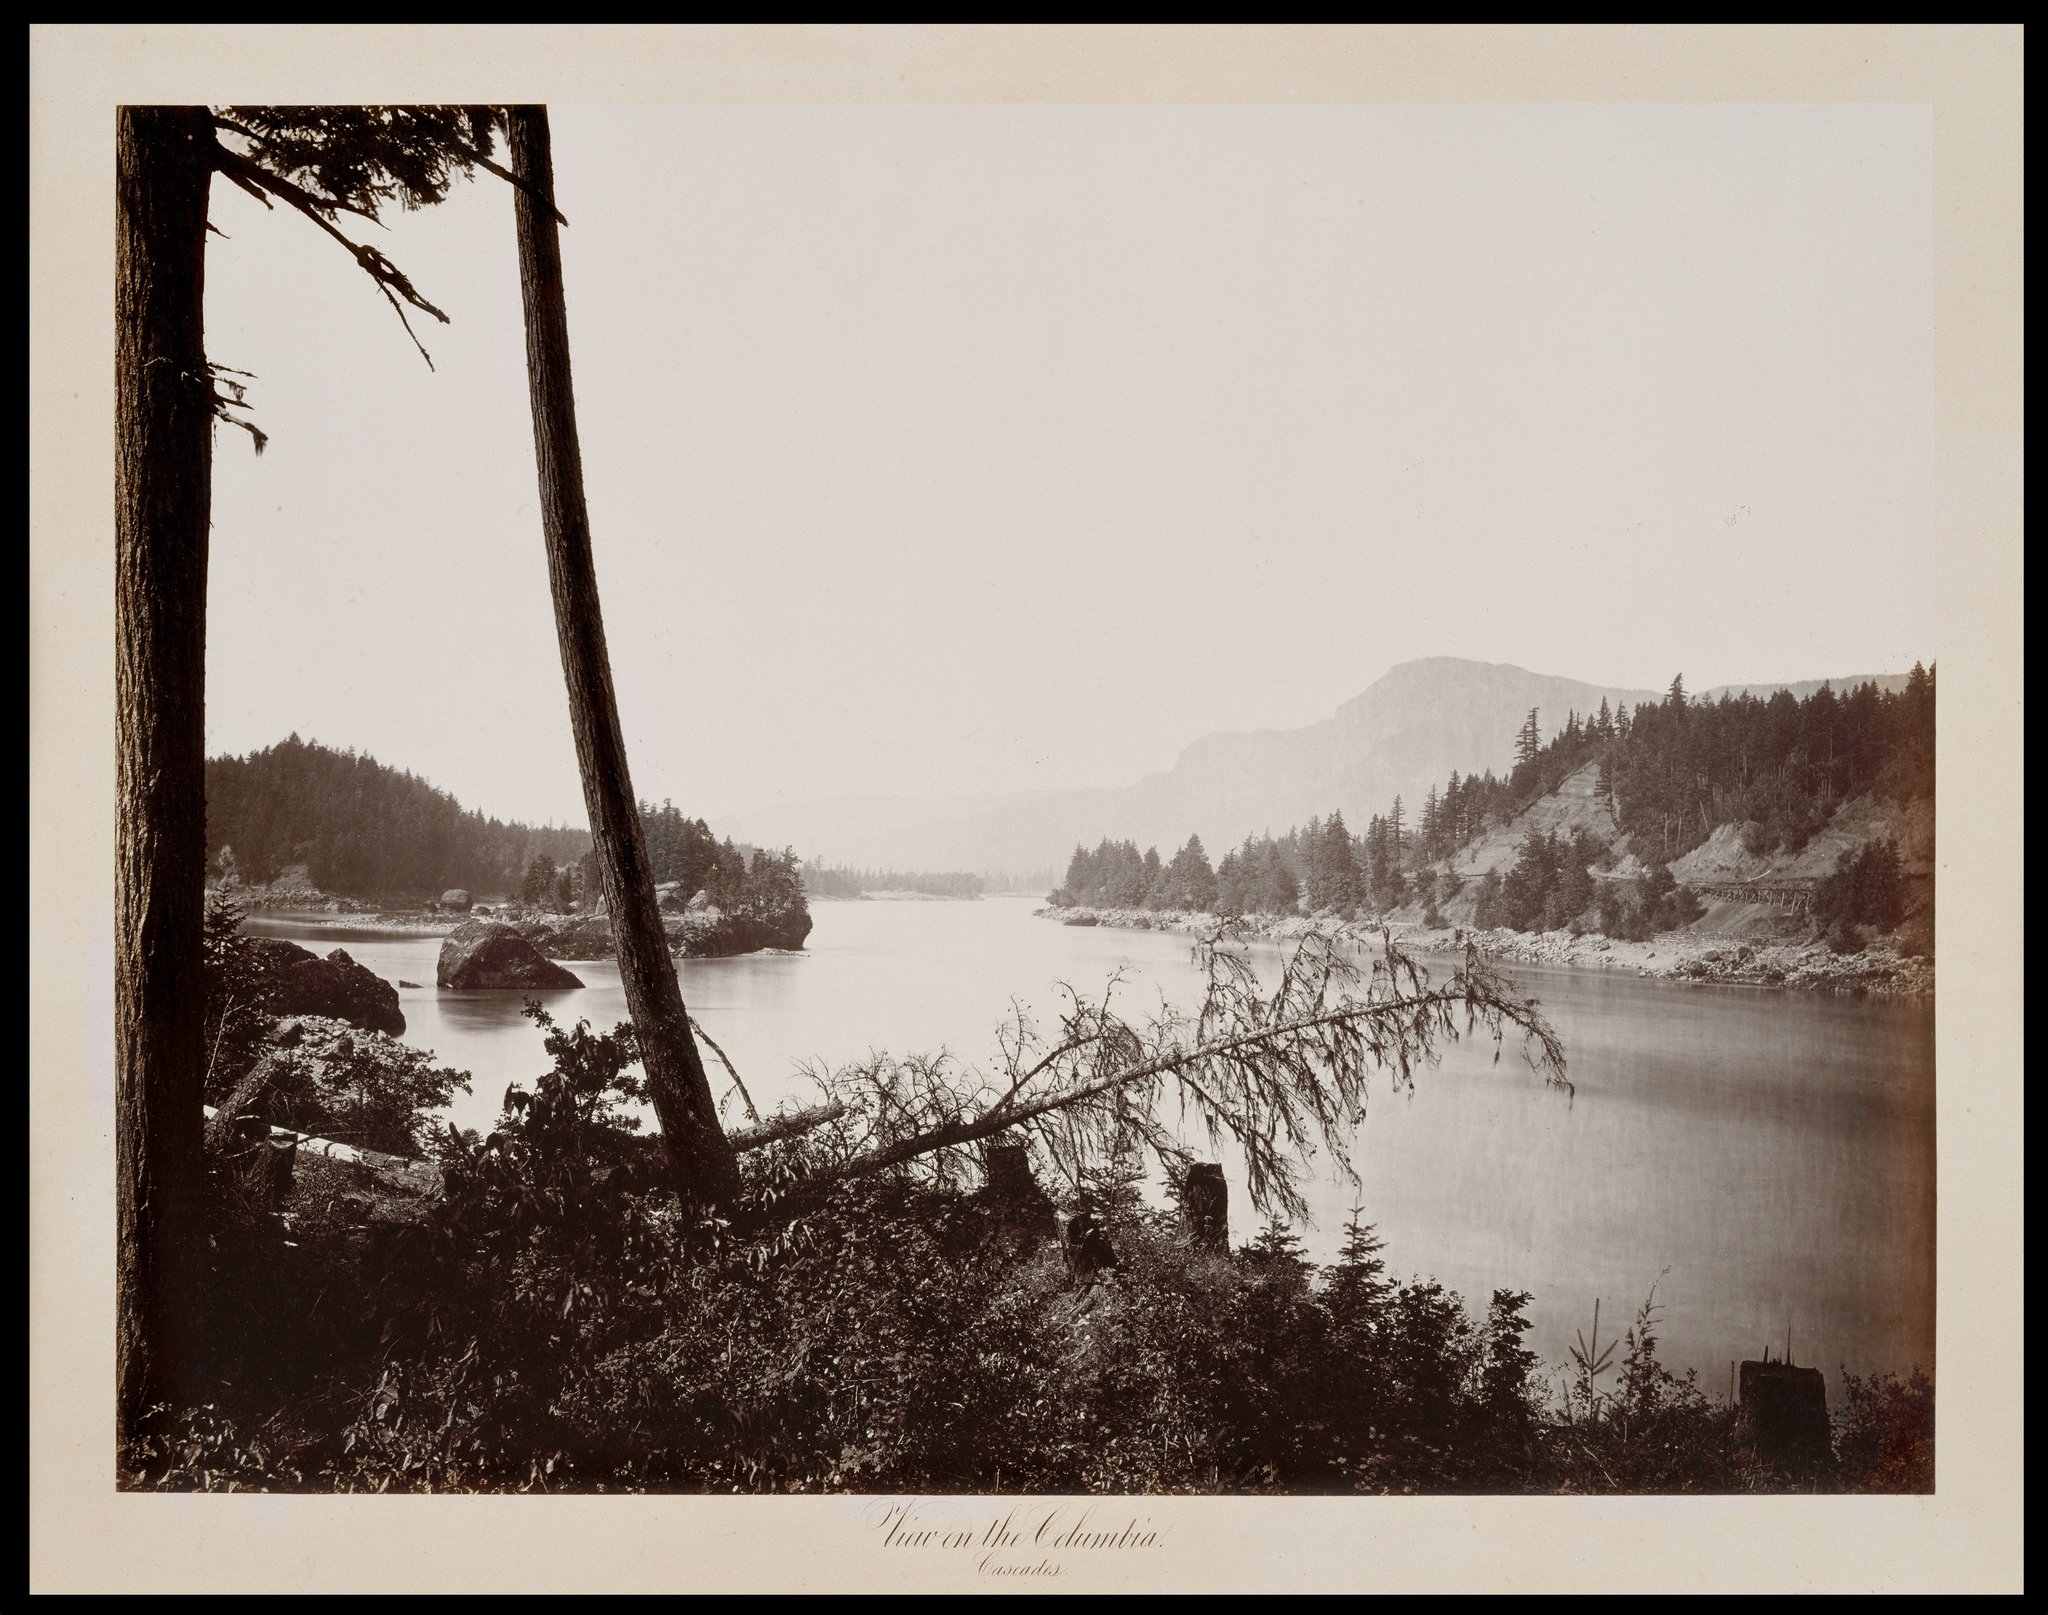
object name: photograph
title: View on the Columbia, Cascades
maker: carleton e. watkins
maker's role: artist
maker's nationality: american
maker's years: 1829-1916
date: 1867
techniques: albumen silver print, glass negative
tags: rivers,landscapes